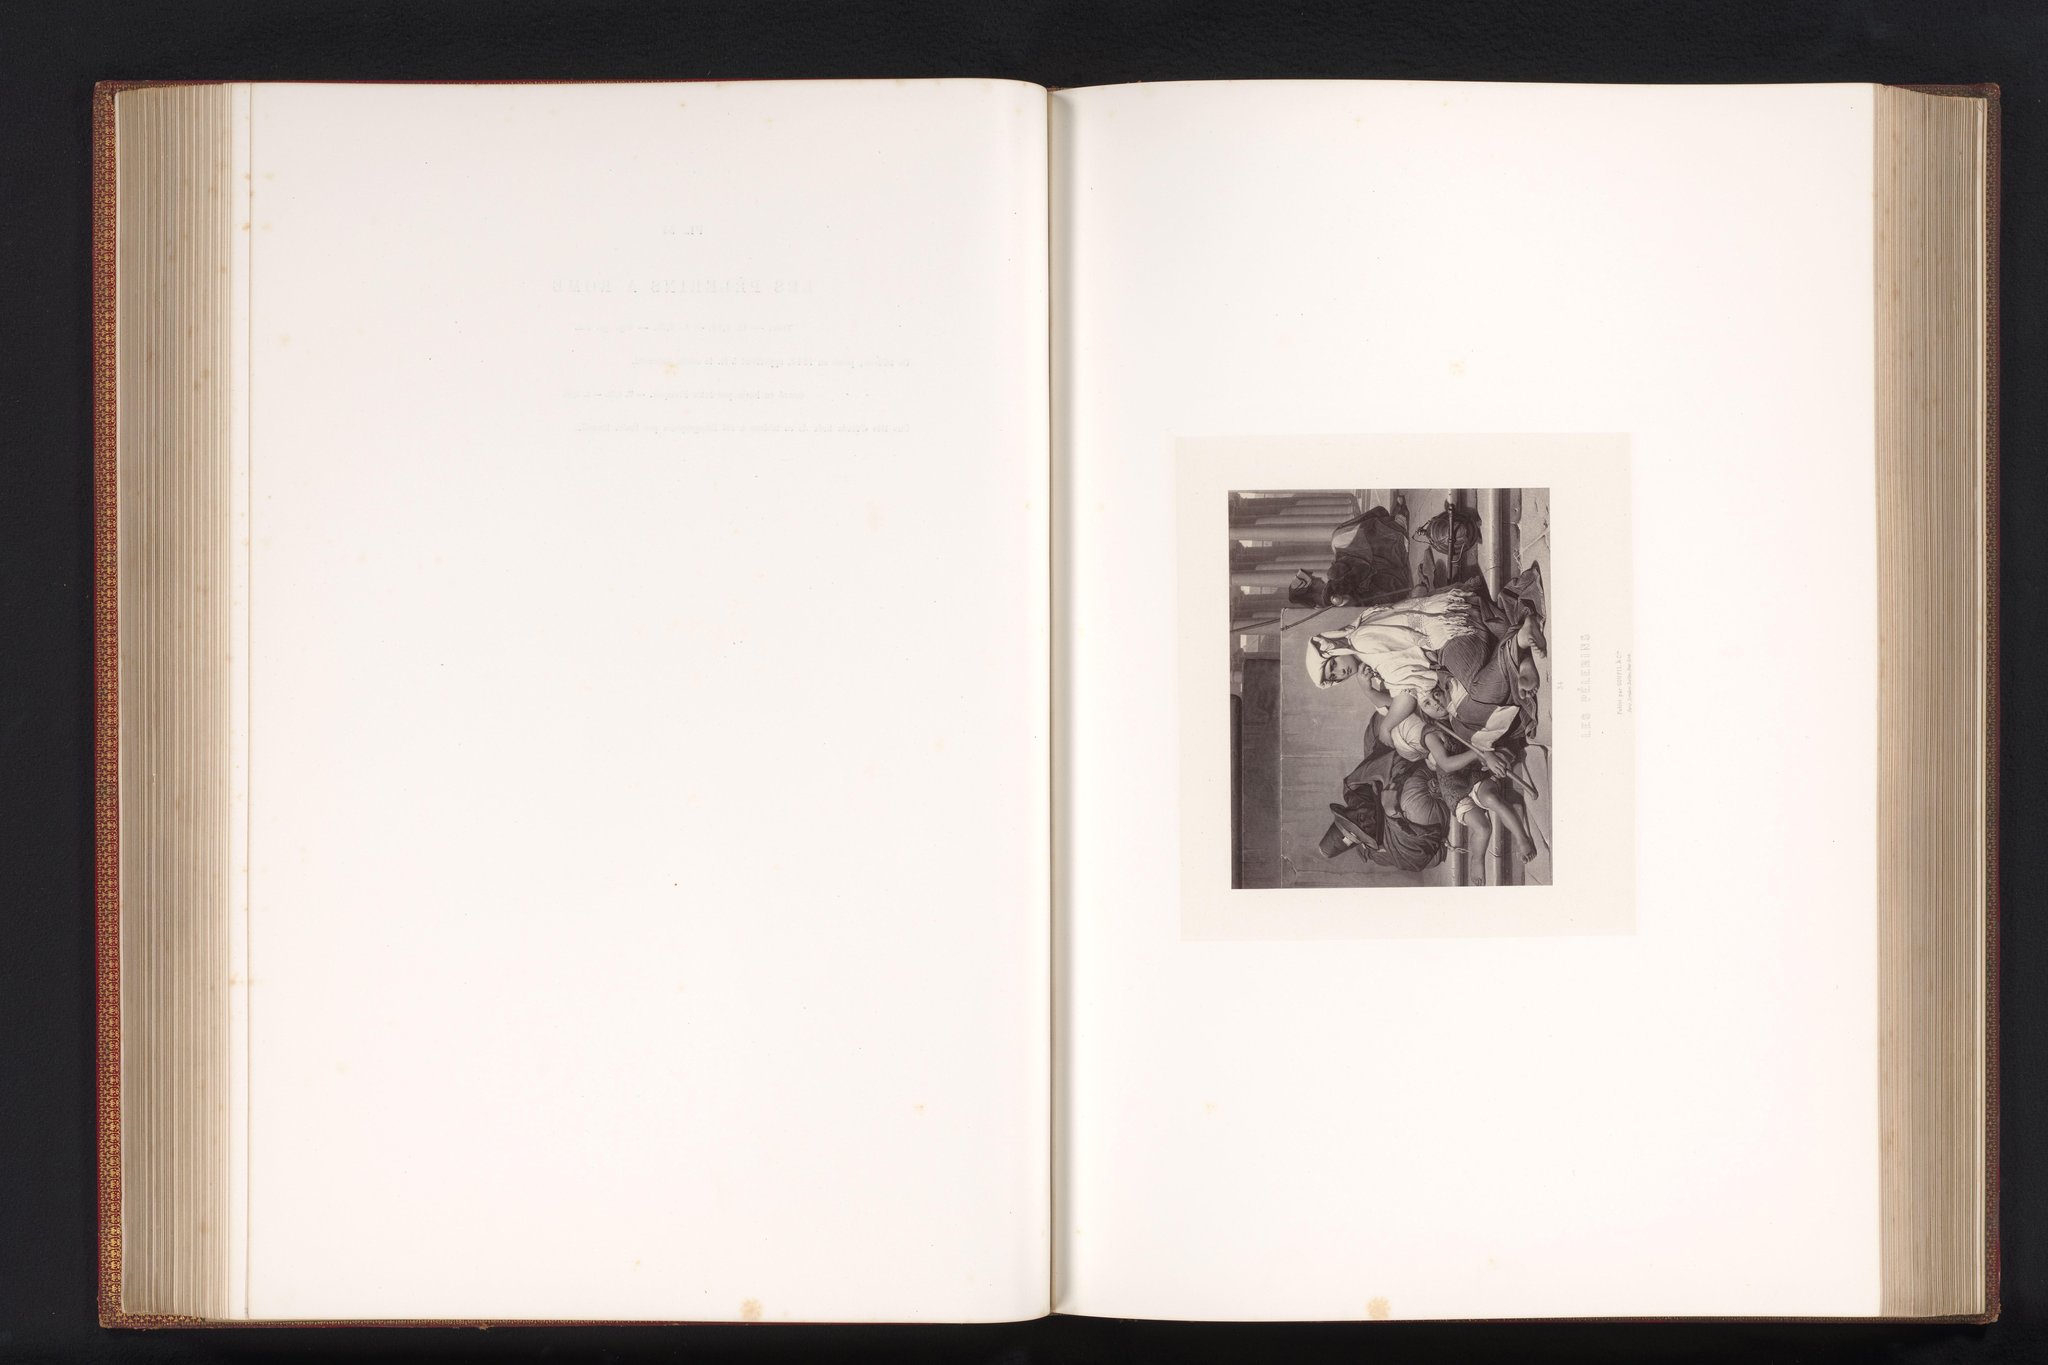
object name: reproduction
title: Fotoreproductie van een prent naar een schilderij van pelgrims in Rome door Paul Delaroche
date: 1853-1858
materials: paper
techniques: albumen print, engraving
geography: paris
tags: pilgrim(s), rome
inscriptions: check stamp: ‘Goupil & Cie’